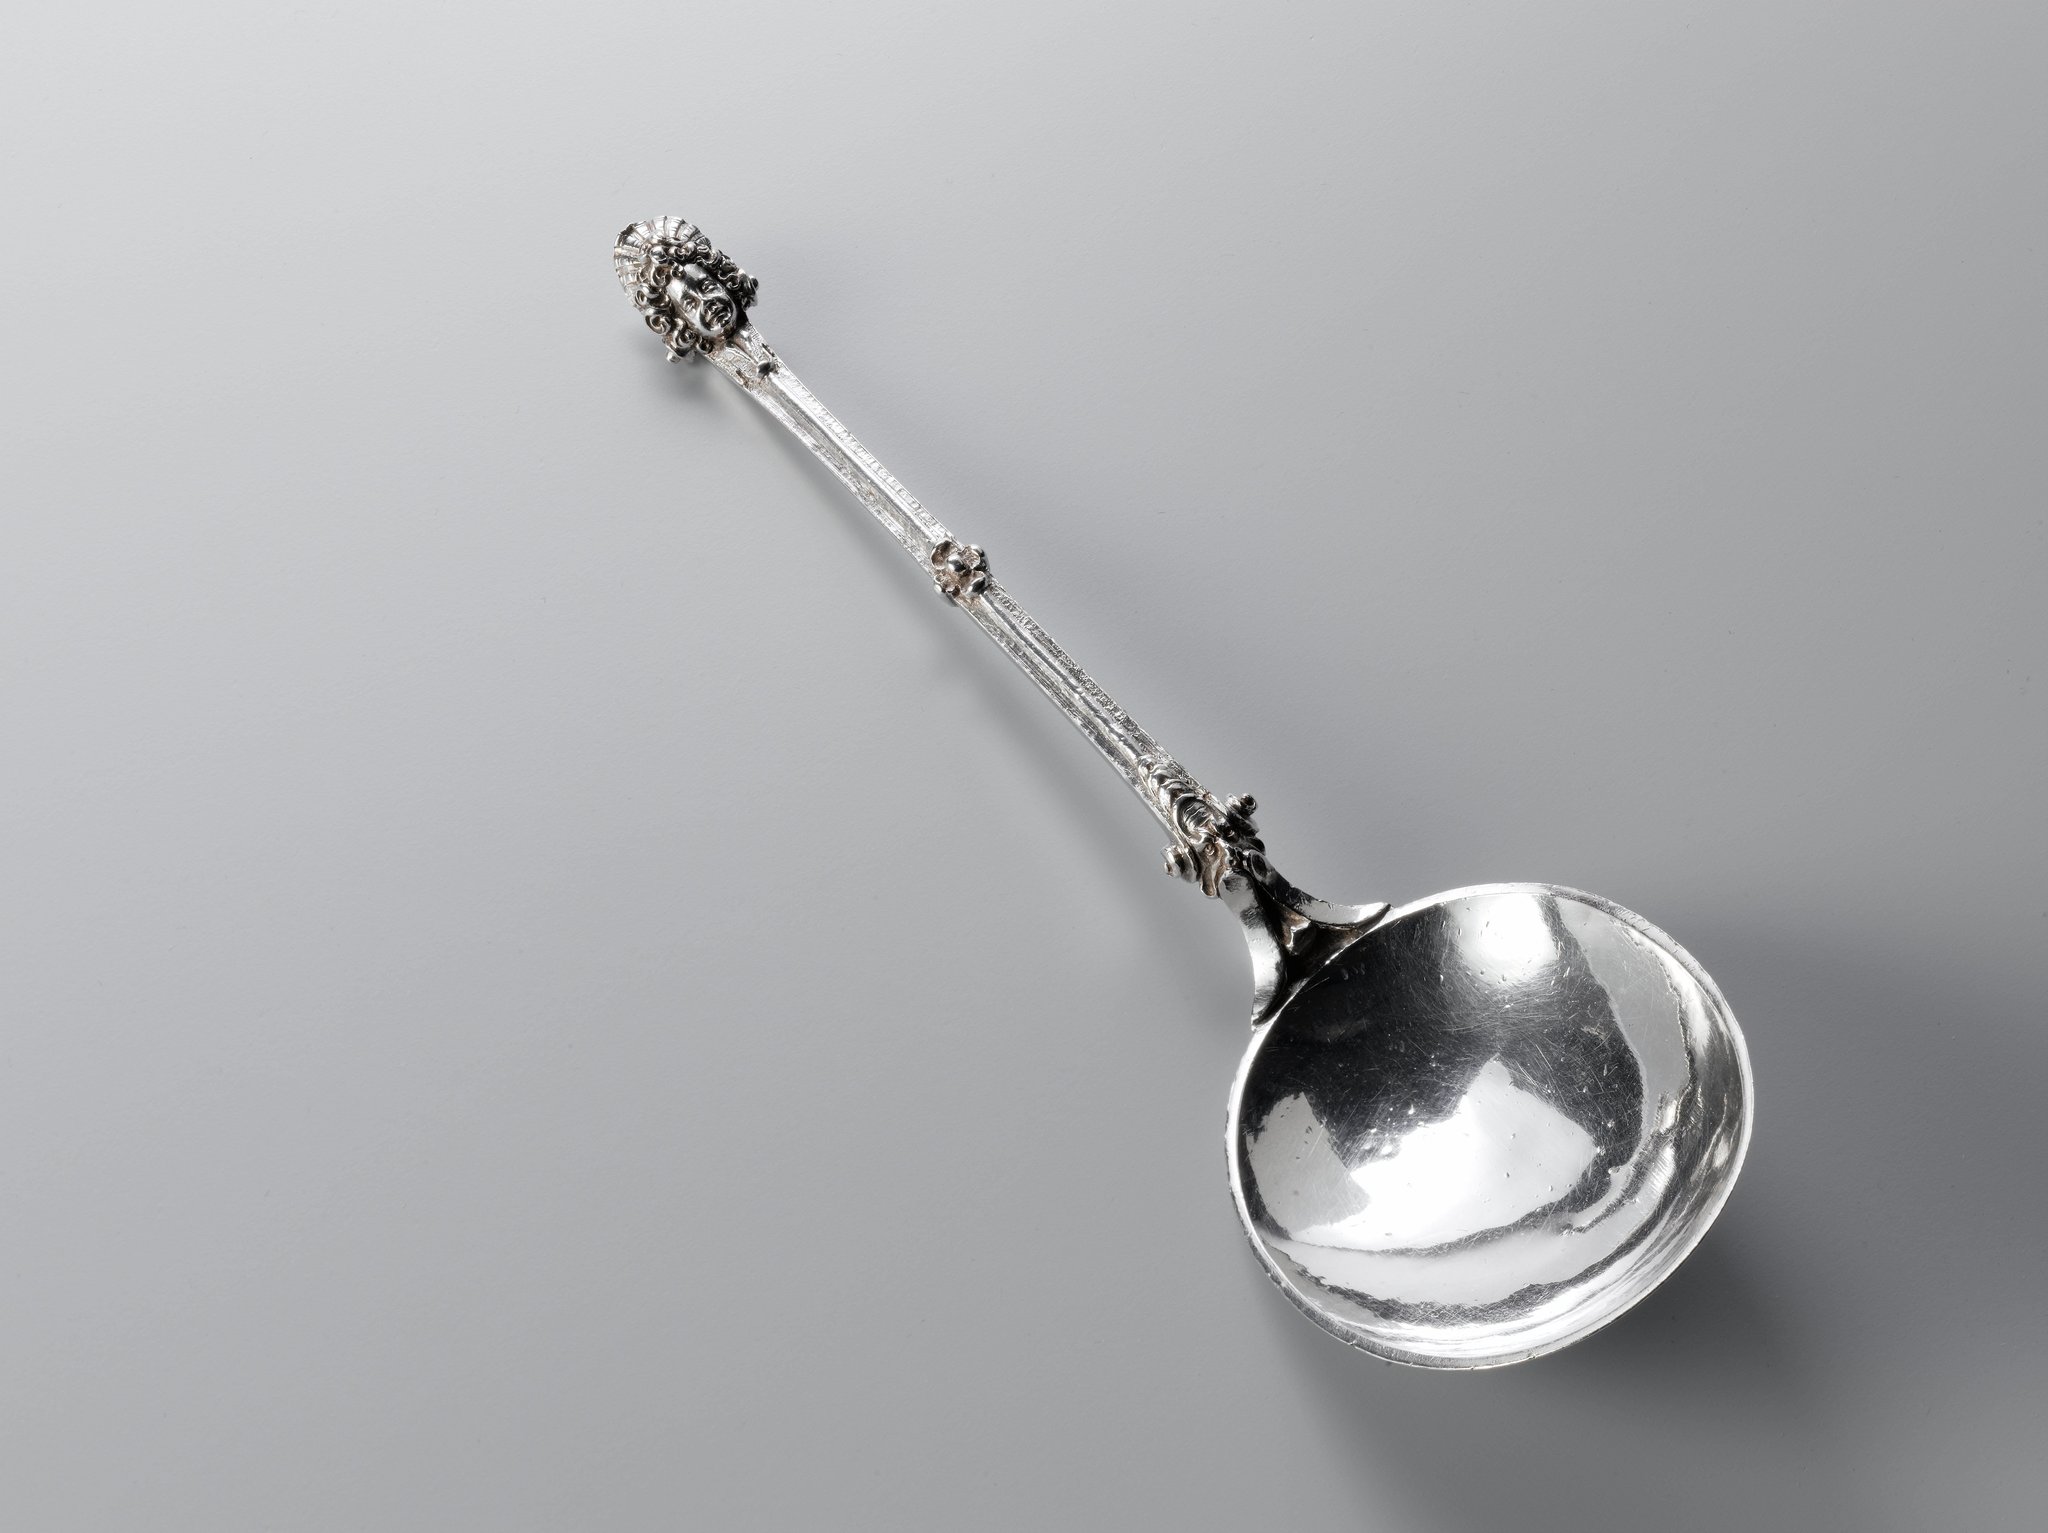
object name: spoon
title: Lepel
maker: Anonymous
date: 1600-1614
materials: silver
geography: low countries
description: Lepel van zilver, met een ovale bak. De steel wordt bekroond door een vrouwenhoofd met een schelp.